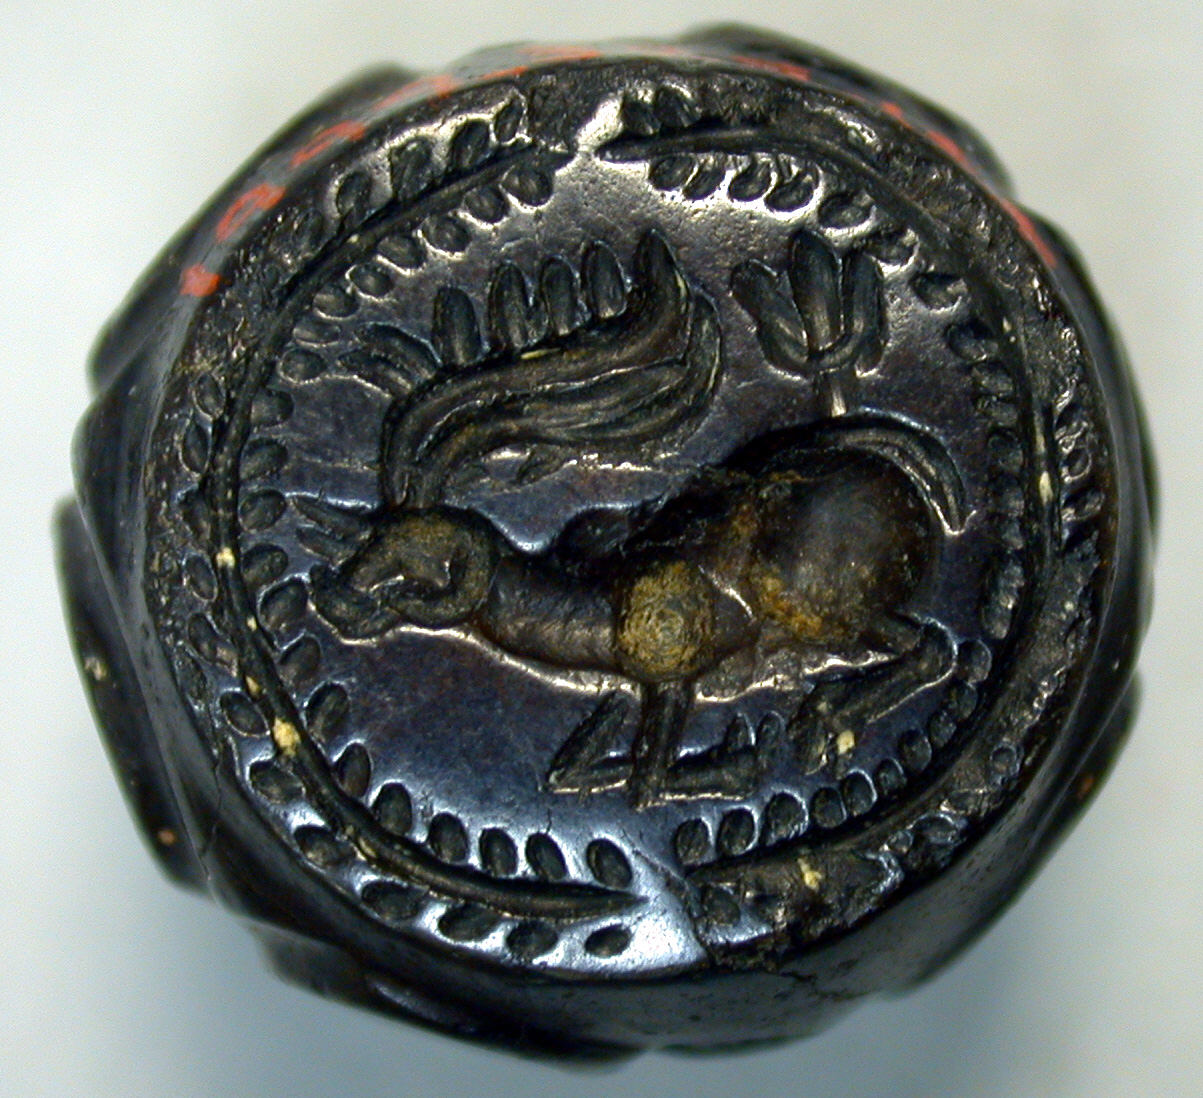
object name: stamp seal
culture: sasanian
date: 201-700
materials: mineral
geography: iran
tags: animals